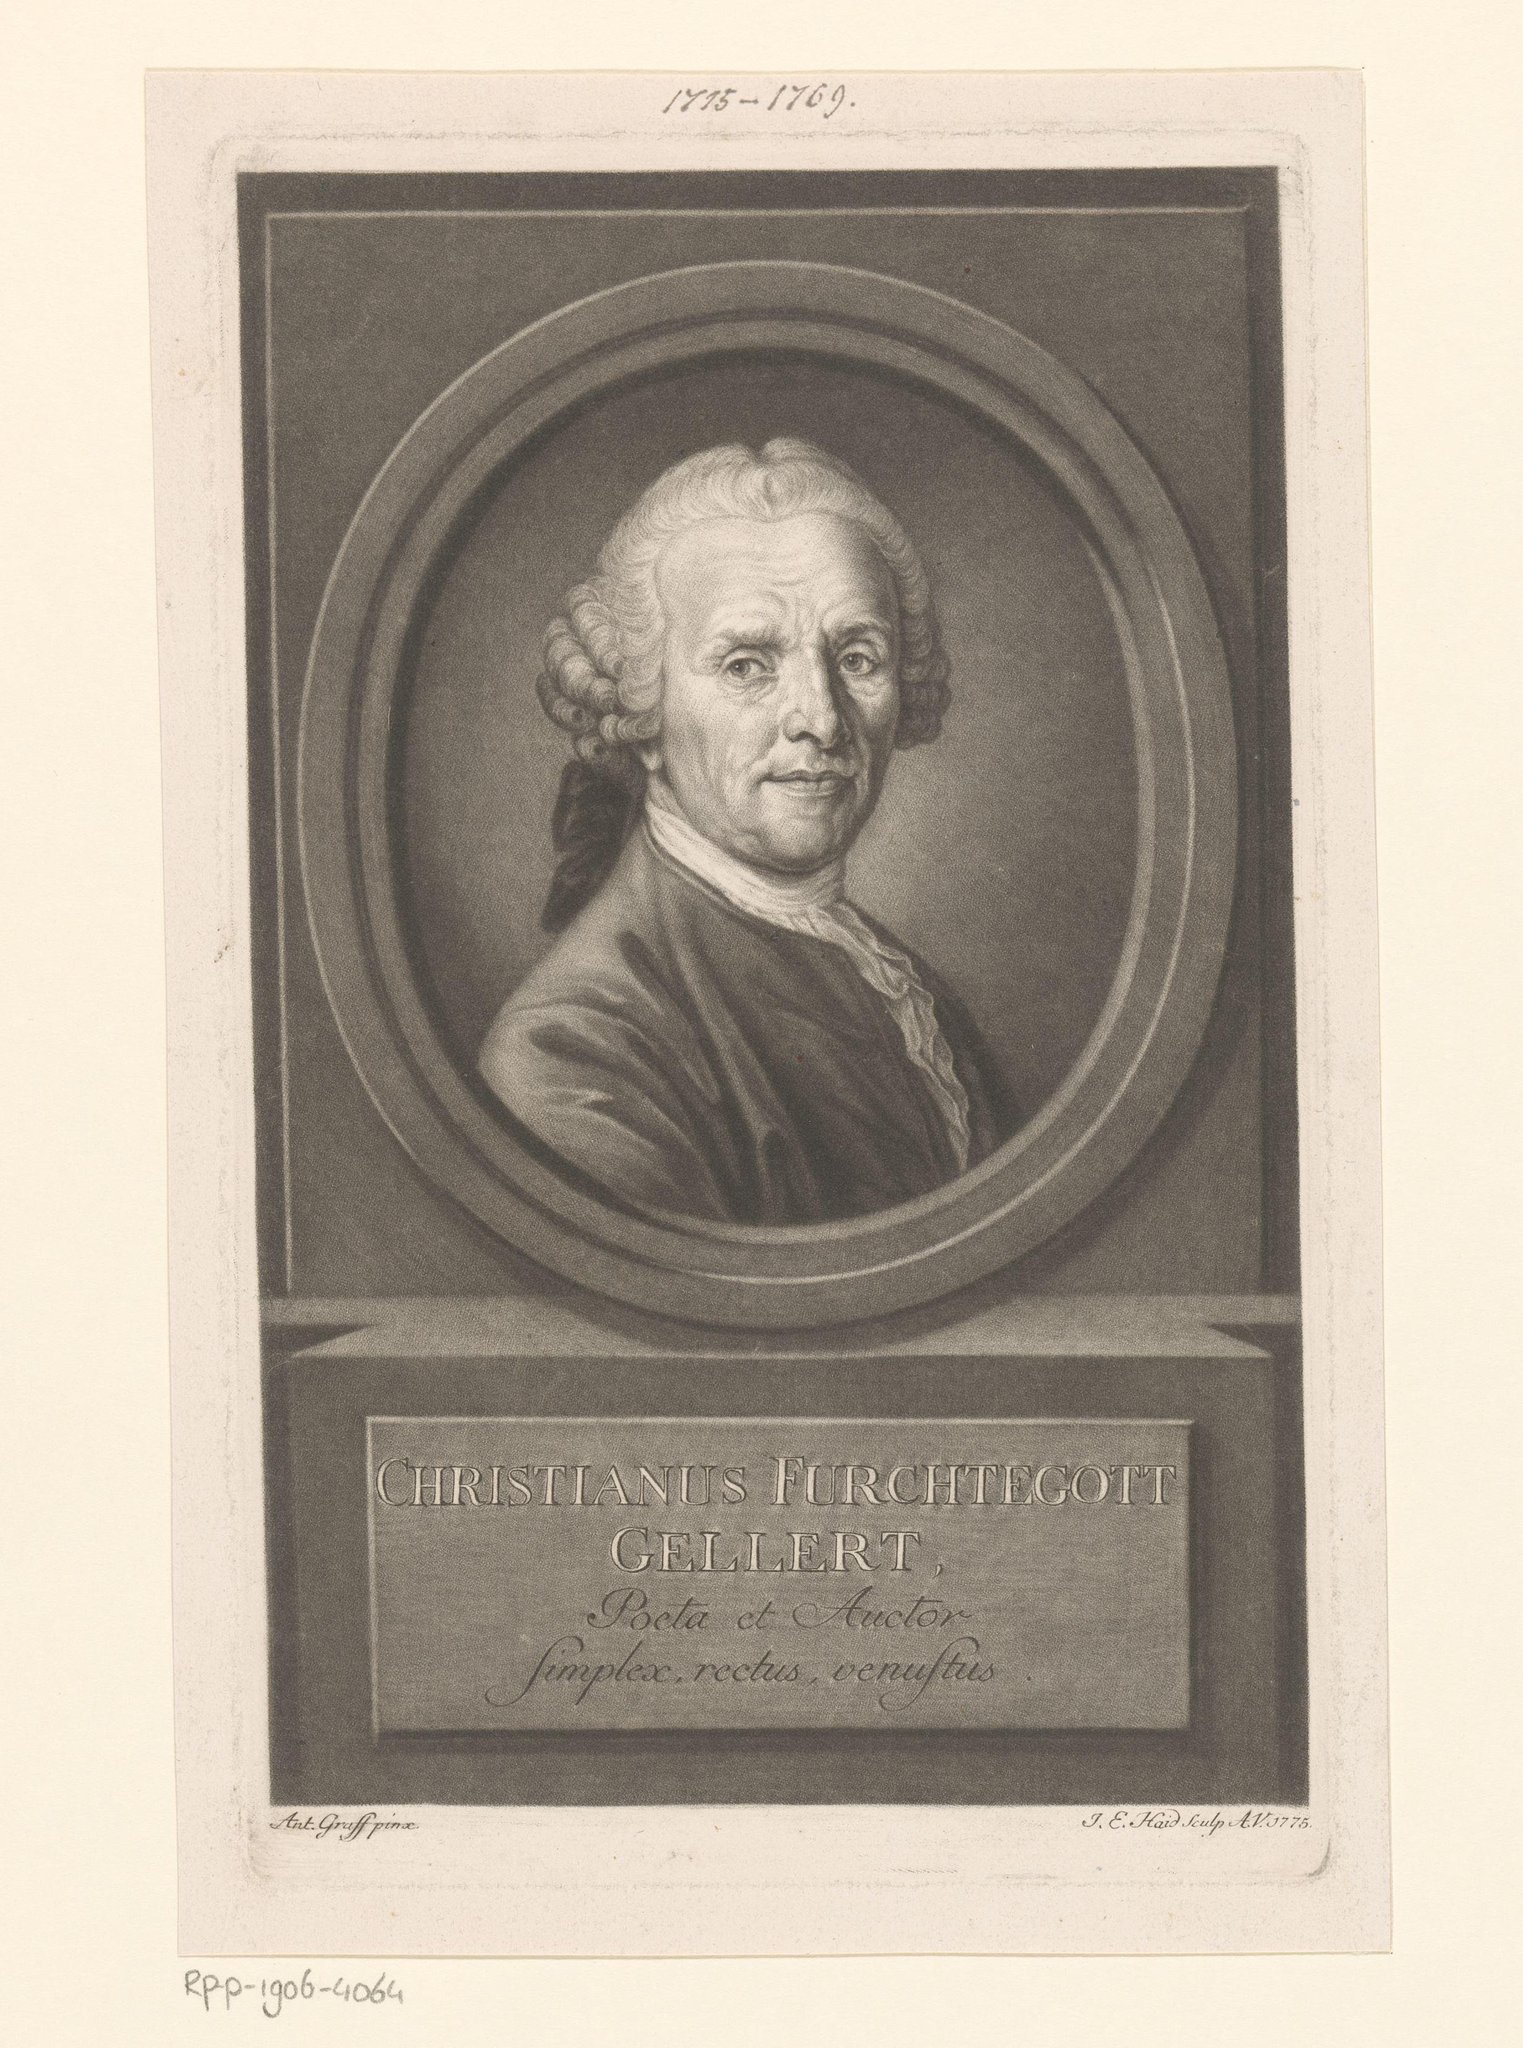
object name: print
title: Portret van Christian Fürchtegott Gellert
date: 1775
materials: paper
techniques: mezzotint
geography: augsburg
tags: historical persons, portrait of a writer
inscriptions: collector's mark: Lugt 2228